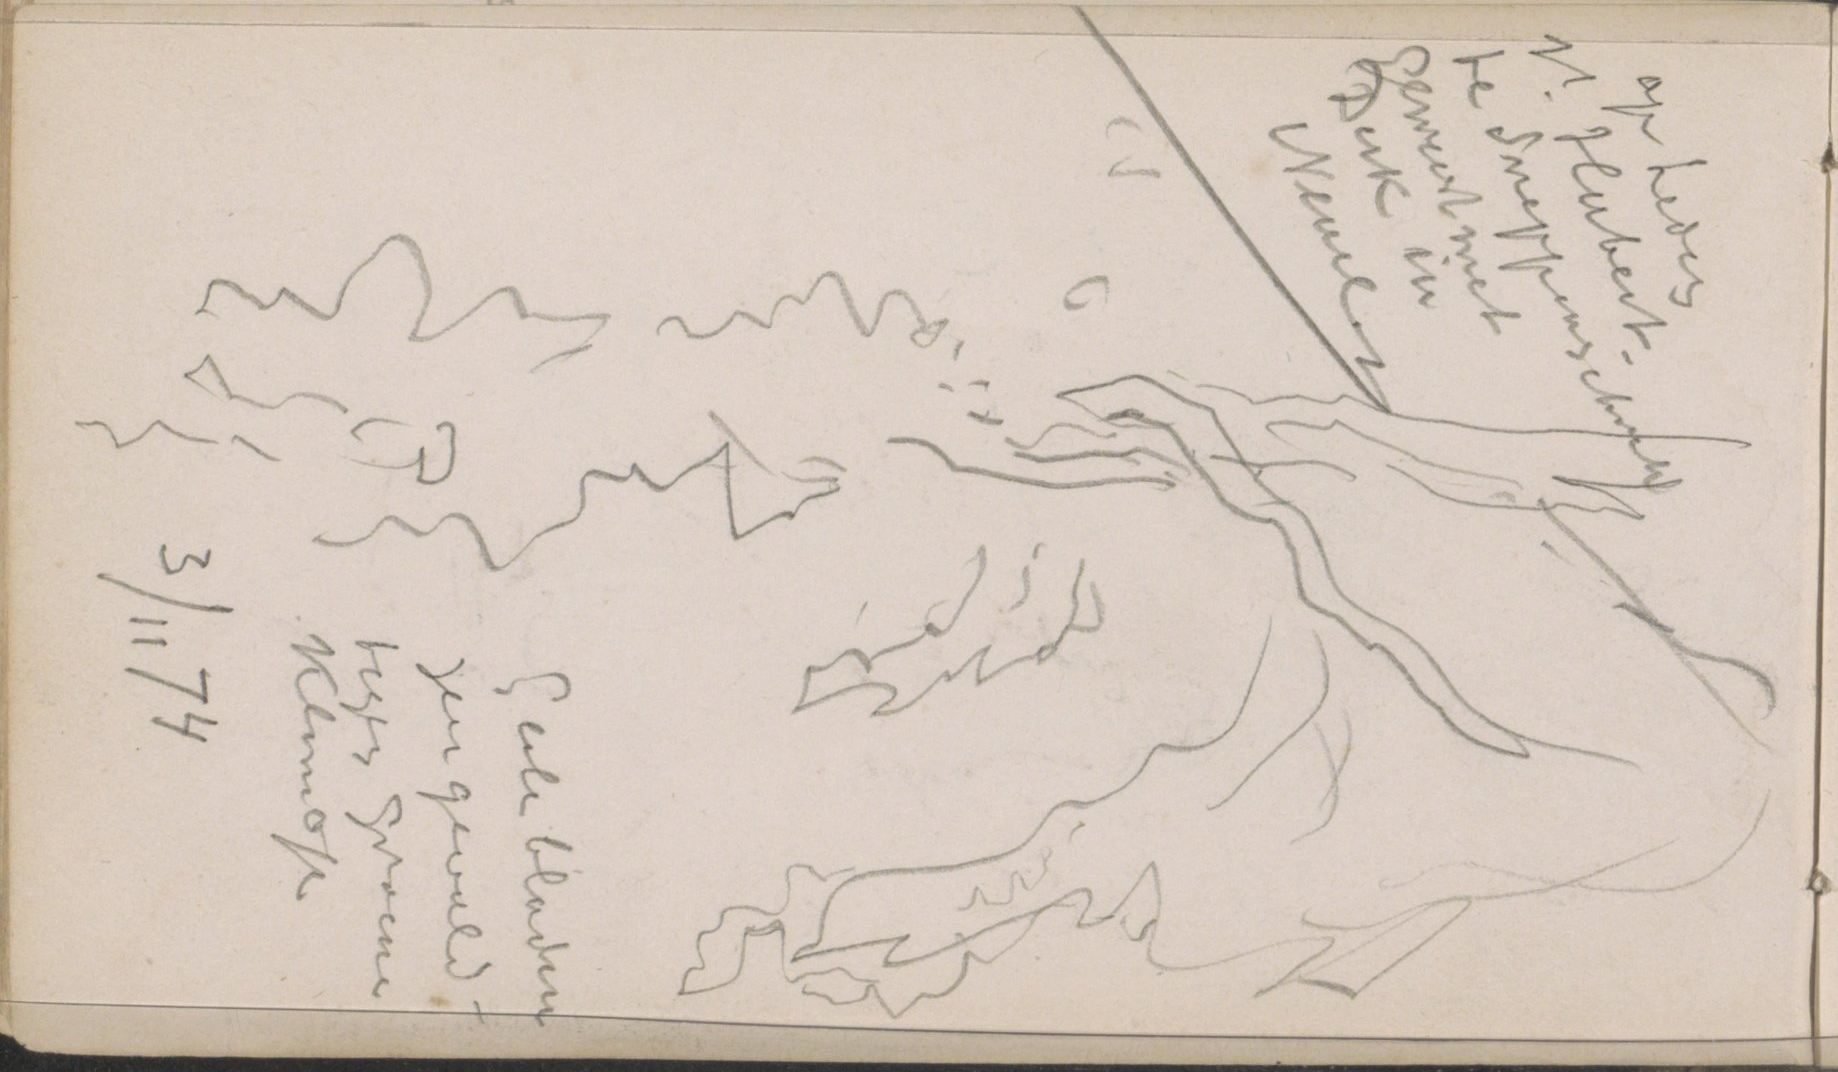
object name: sketchbook leaf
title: Boerenhuizen aan de Schie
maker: johannes tavenraat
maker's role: draughtsman, painter, print maker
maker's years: 1809-1881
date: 1809-1876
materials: paper, pencil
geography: delftse schie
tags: city-view, and landscape with man-made constructions, rural housing, e.g. country-house, villa, cottage, delft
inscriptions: date and inscription: ‘16 September 76. met Dirk mijn huwelijksdag herdacht & W.[...] verjaardag/ Schie’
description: Blad 33 verso en 34 recto uit een schetsboek met 46 bladen.